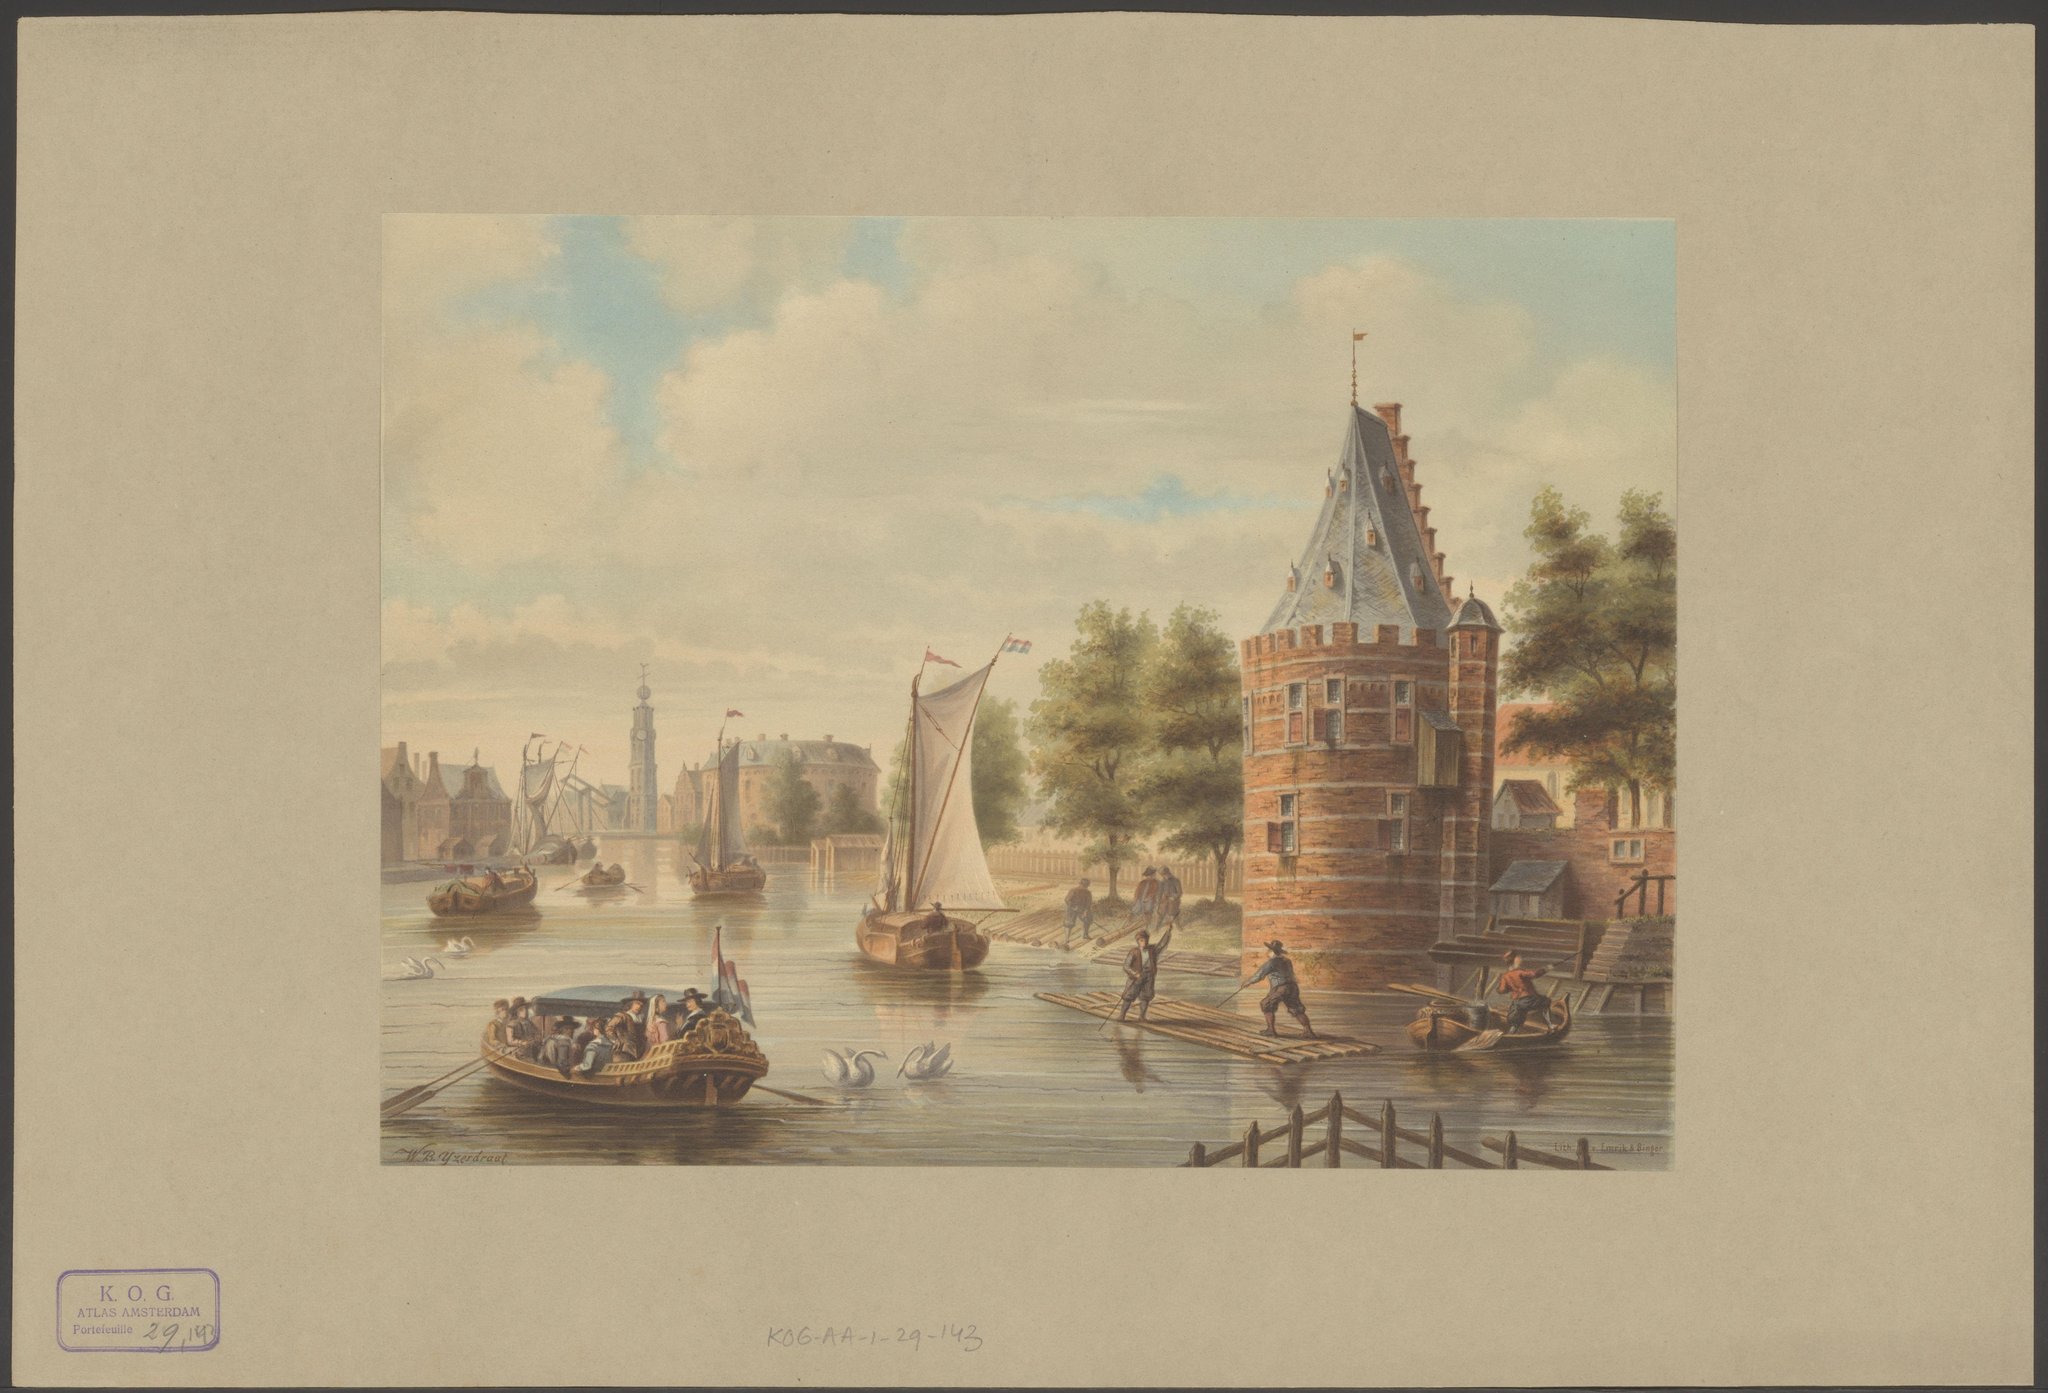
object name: print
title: Gezicht op de toren Swych Utrecht te Amsterdam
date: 1857-1907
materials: paper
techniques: lithograph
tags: sailing-ship, sailing-boat, tower, clock tower ~ monumental adornment, towers ~ fortified city, water-birds: swan, rowing-boat, canoe, etc., canals, waters (in city) (+ city(-scape) with figures, staffage)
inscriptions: collector's mark: Lugt 1641b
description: Onderwerpsrubriek binnen de Atlas Amsterdam: Swijgt Utrecht.